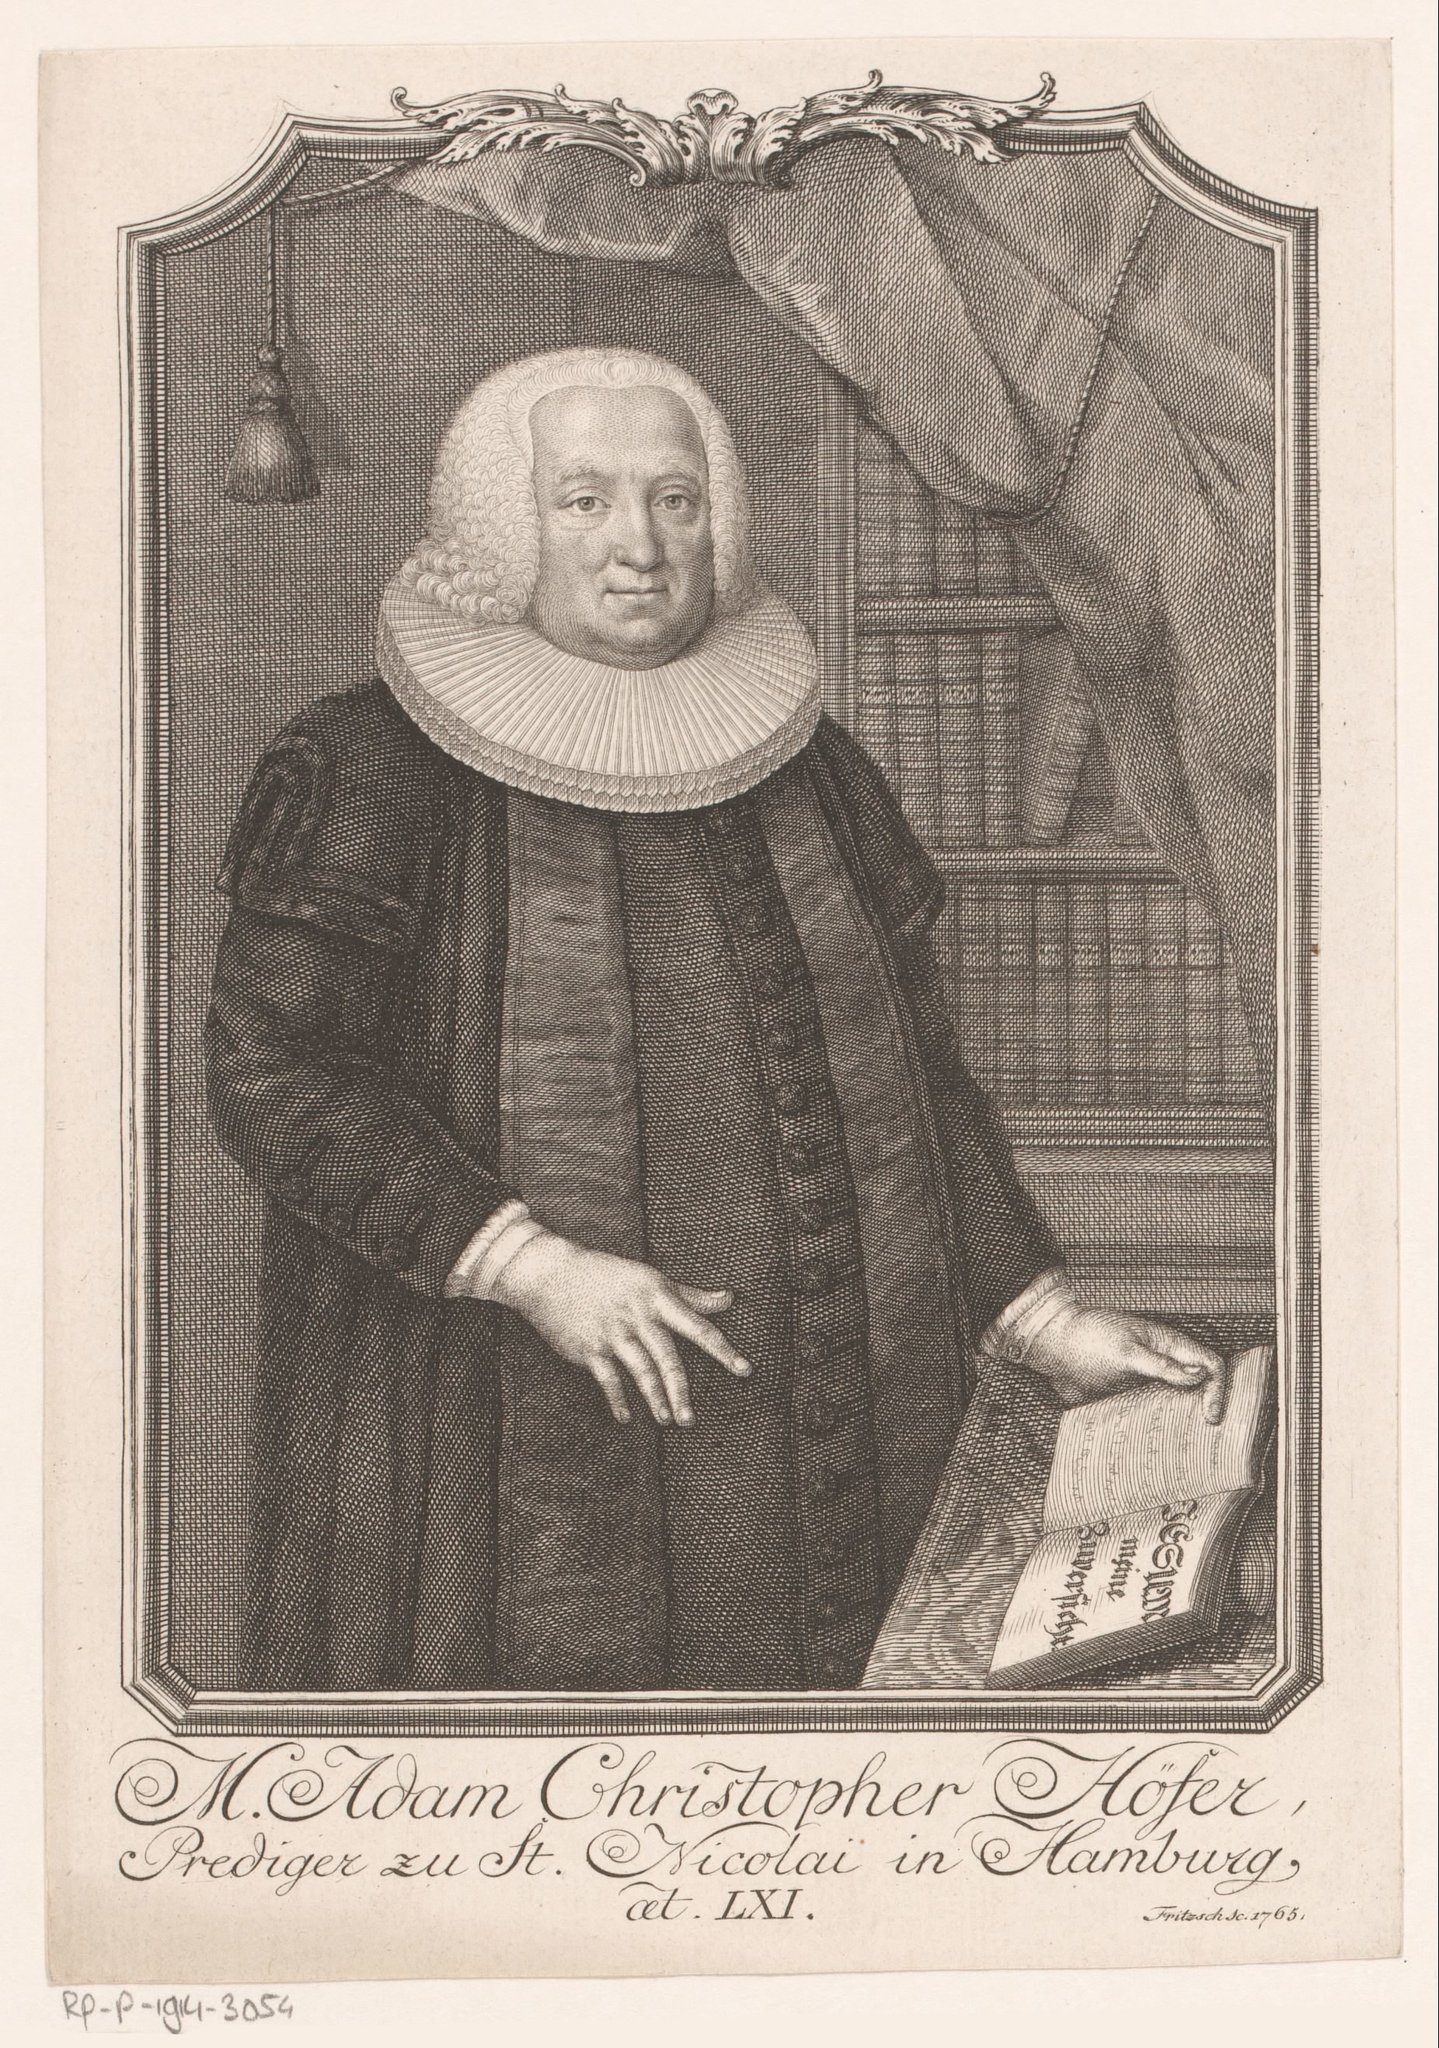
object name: print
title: Portret van Adam Christoph Höfer op 61-jarige leeftijd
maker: christian fritzsch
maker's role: print maker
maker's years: 1695-1769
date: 1765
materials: paper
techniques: engraving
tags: bookshelves, historical persons, book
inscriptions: collector's mark: Lugt 2228